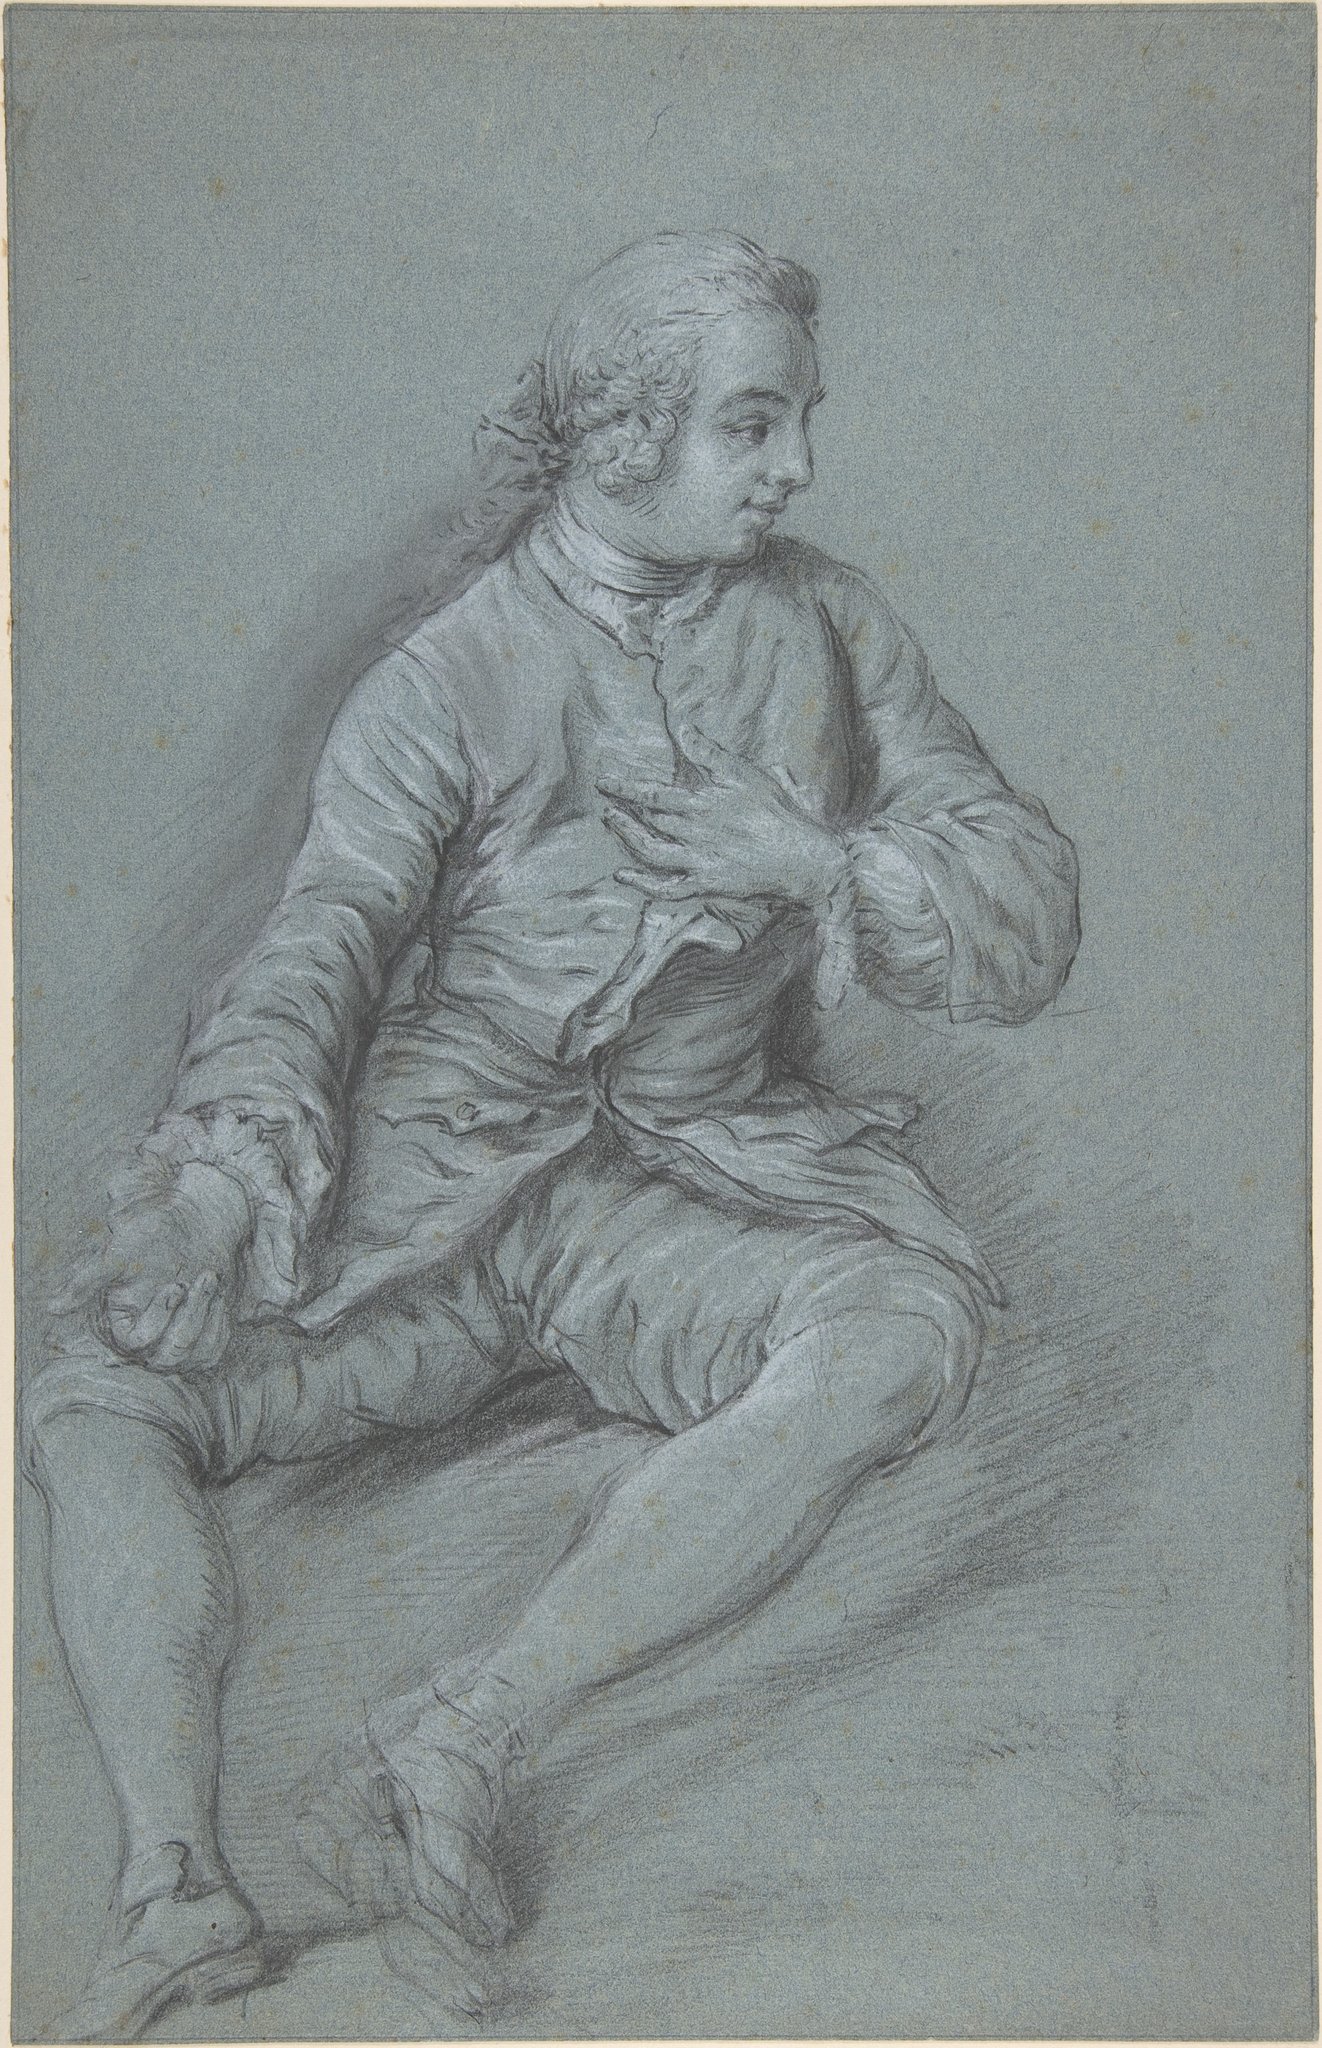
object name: drawing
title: Young Man Seated on the ground with his left hand at his chest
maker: anonymous, french, 18th century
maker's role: artist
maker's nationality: french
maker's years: 1700-1800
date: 1701-1800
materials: chalk, paper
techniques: heightening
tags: men